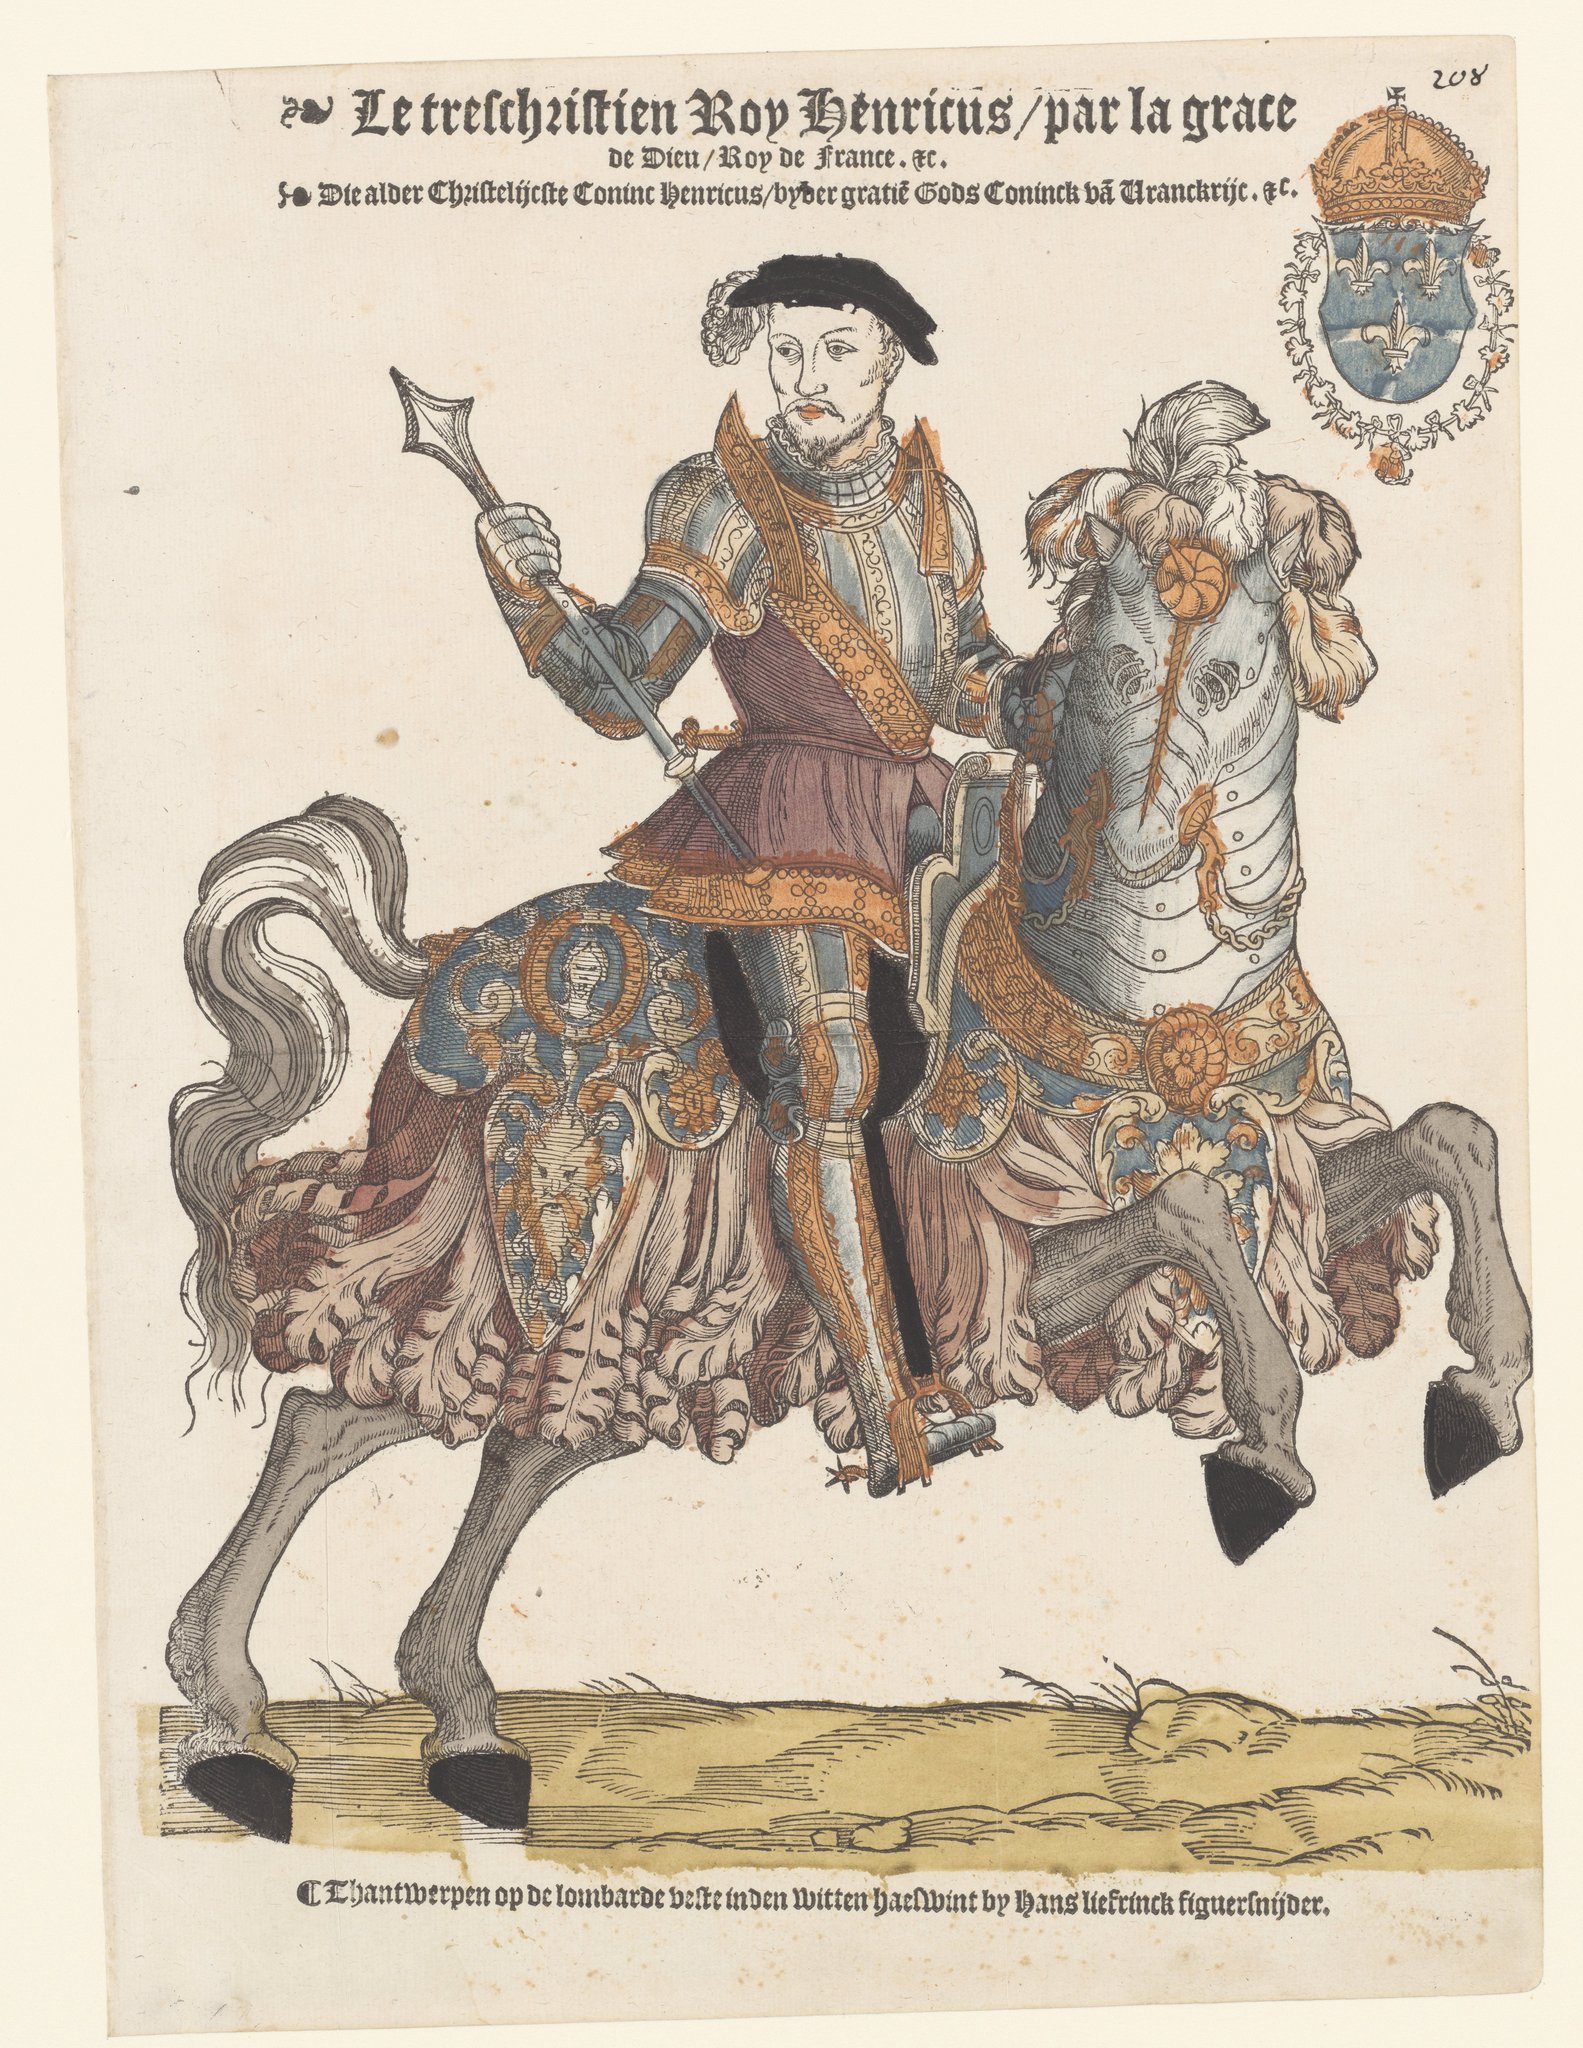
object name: print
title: Portret van Hendrik II van Frankrijk in harnas te paard, naar rechts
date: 1539-1547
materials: paper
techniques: hand coloring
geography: antwerp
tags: paris, equestrian state-portrait, historical persons, king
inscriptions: address: ‘Thantwerpen op de lombarde veste inden witten haeswint by Hans liefrinck figuersnijder’, number: ‘208’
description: Hendrik II van Frankrijk, tweede zoon van Frans I, nam in 1542 als veldheer in het zuiden van Frankrijk deel aan de oorlog tegen Karel V. Koning in 1547. Ruiter in wapenrusting op een paard in galop naar rechts. Gekroond wapen met dolfijnen rechtsboven (eerste staat) is vervangen door het Franse koningswapen met de Orde van St. Michel.